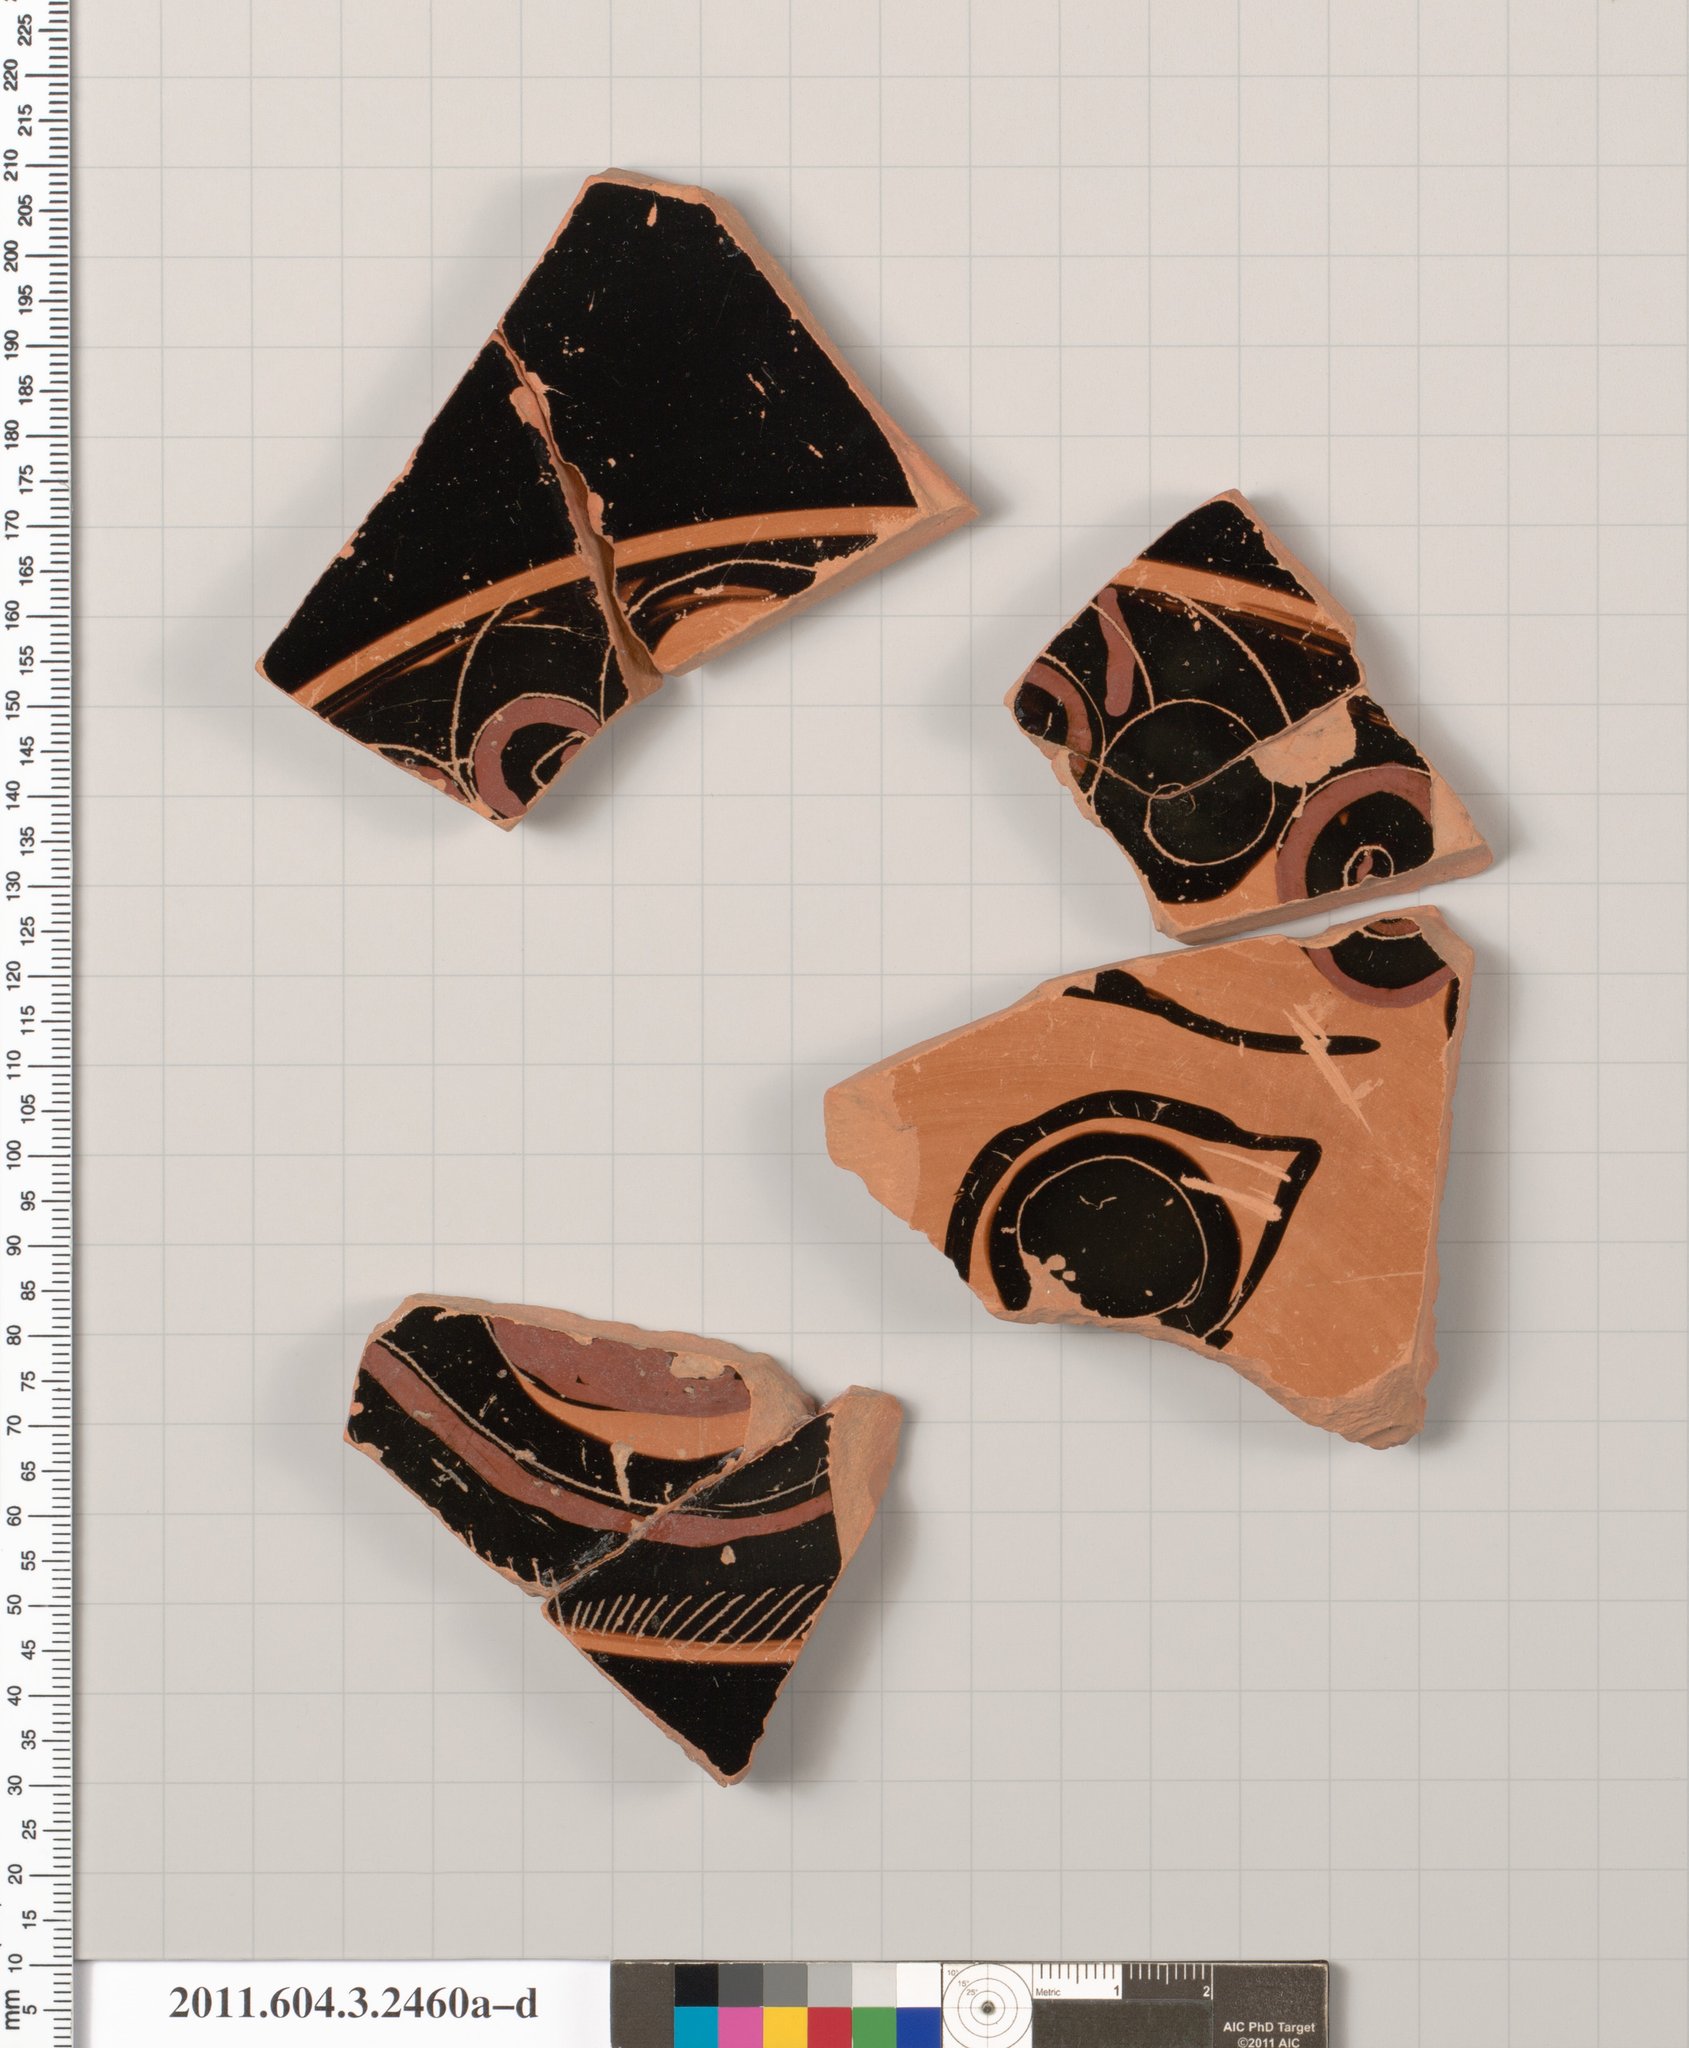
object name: kylix fragment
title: Terracotta fragments of a kylix (drinking cup)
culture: greek, attic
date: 530-500 BCE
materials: terracotta